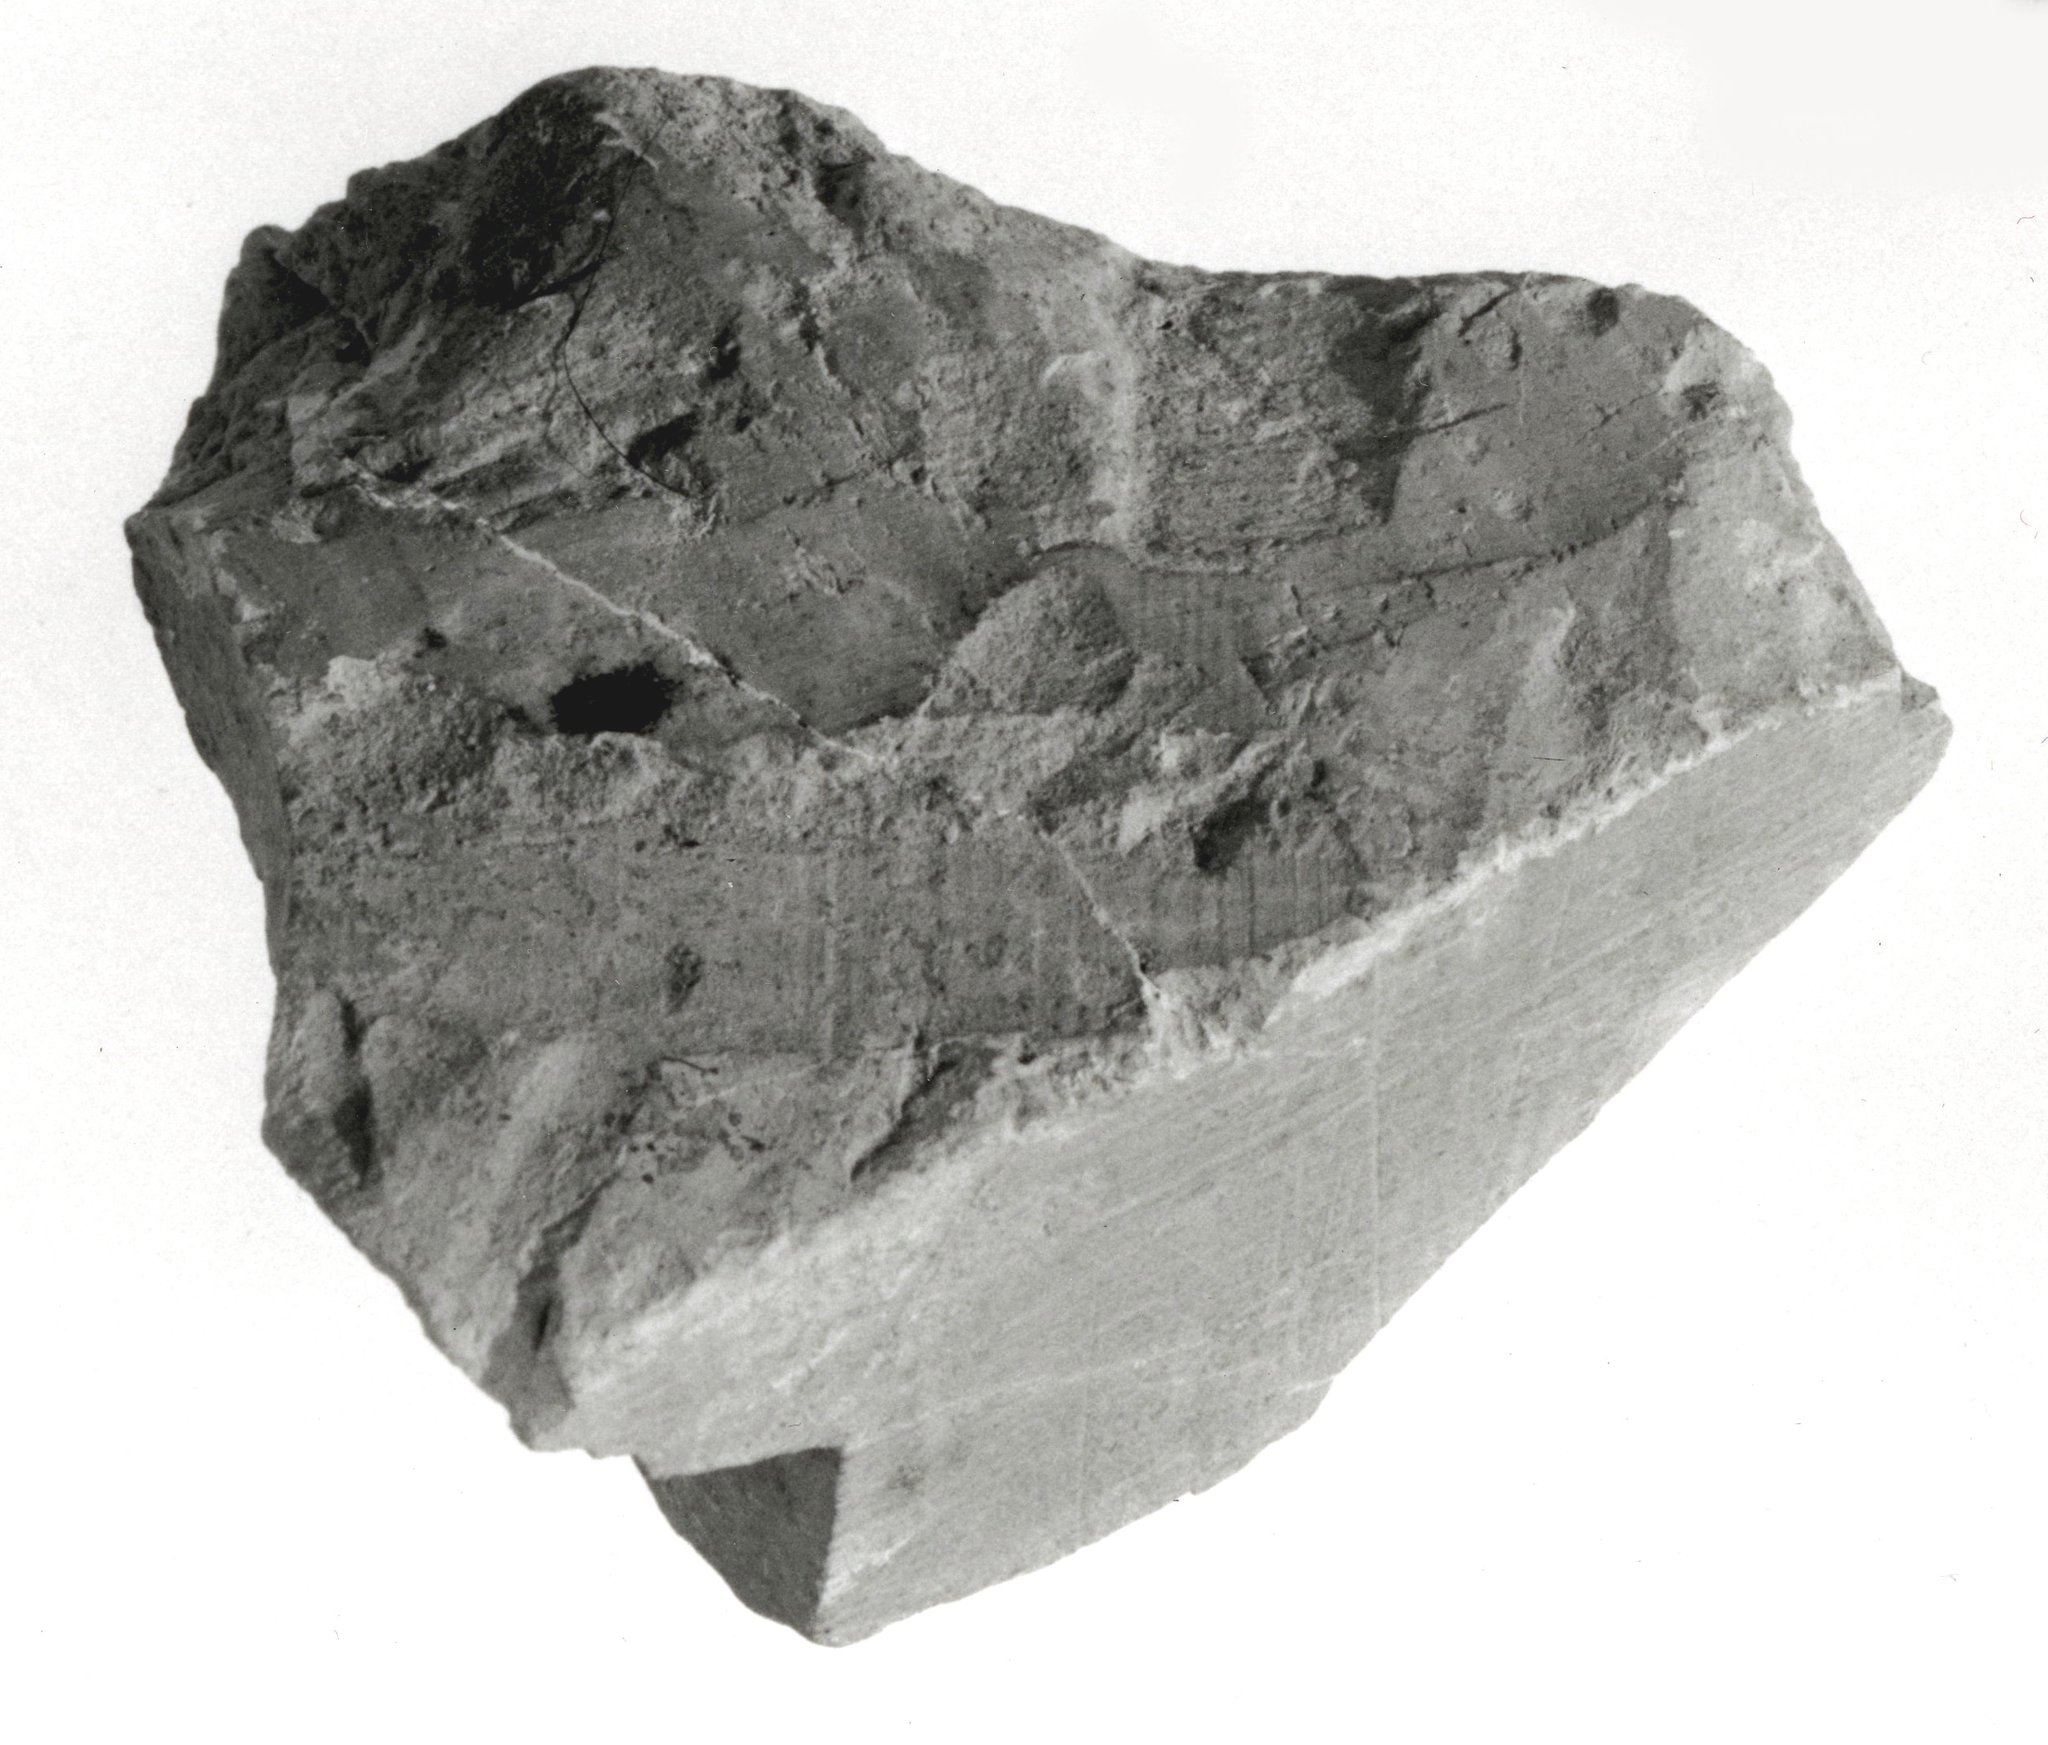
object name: relief, tomb of nespekashuty, wall casing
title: Wall casing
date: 664-610 BCE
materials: limestone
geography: egypt